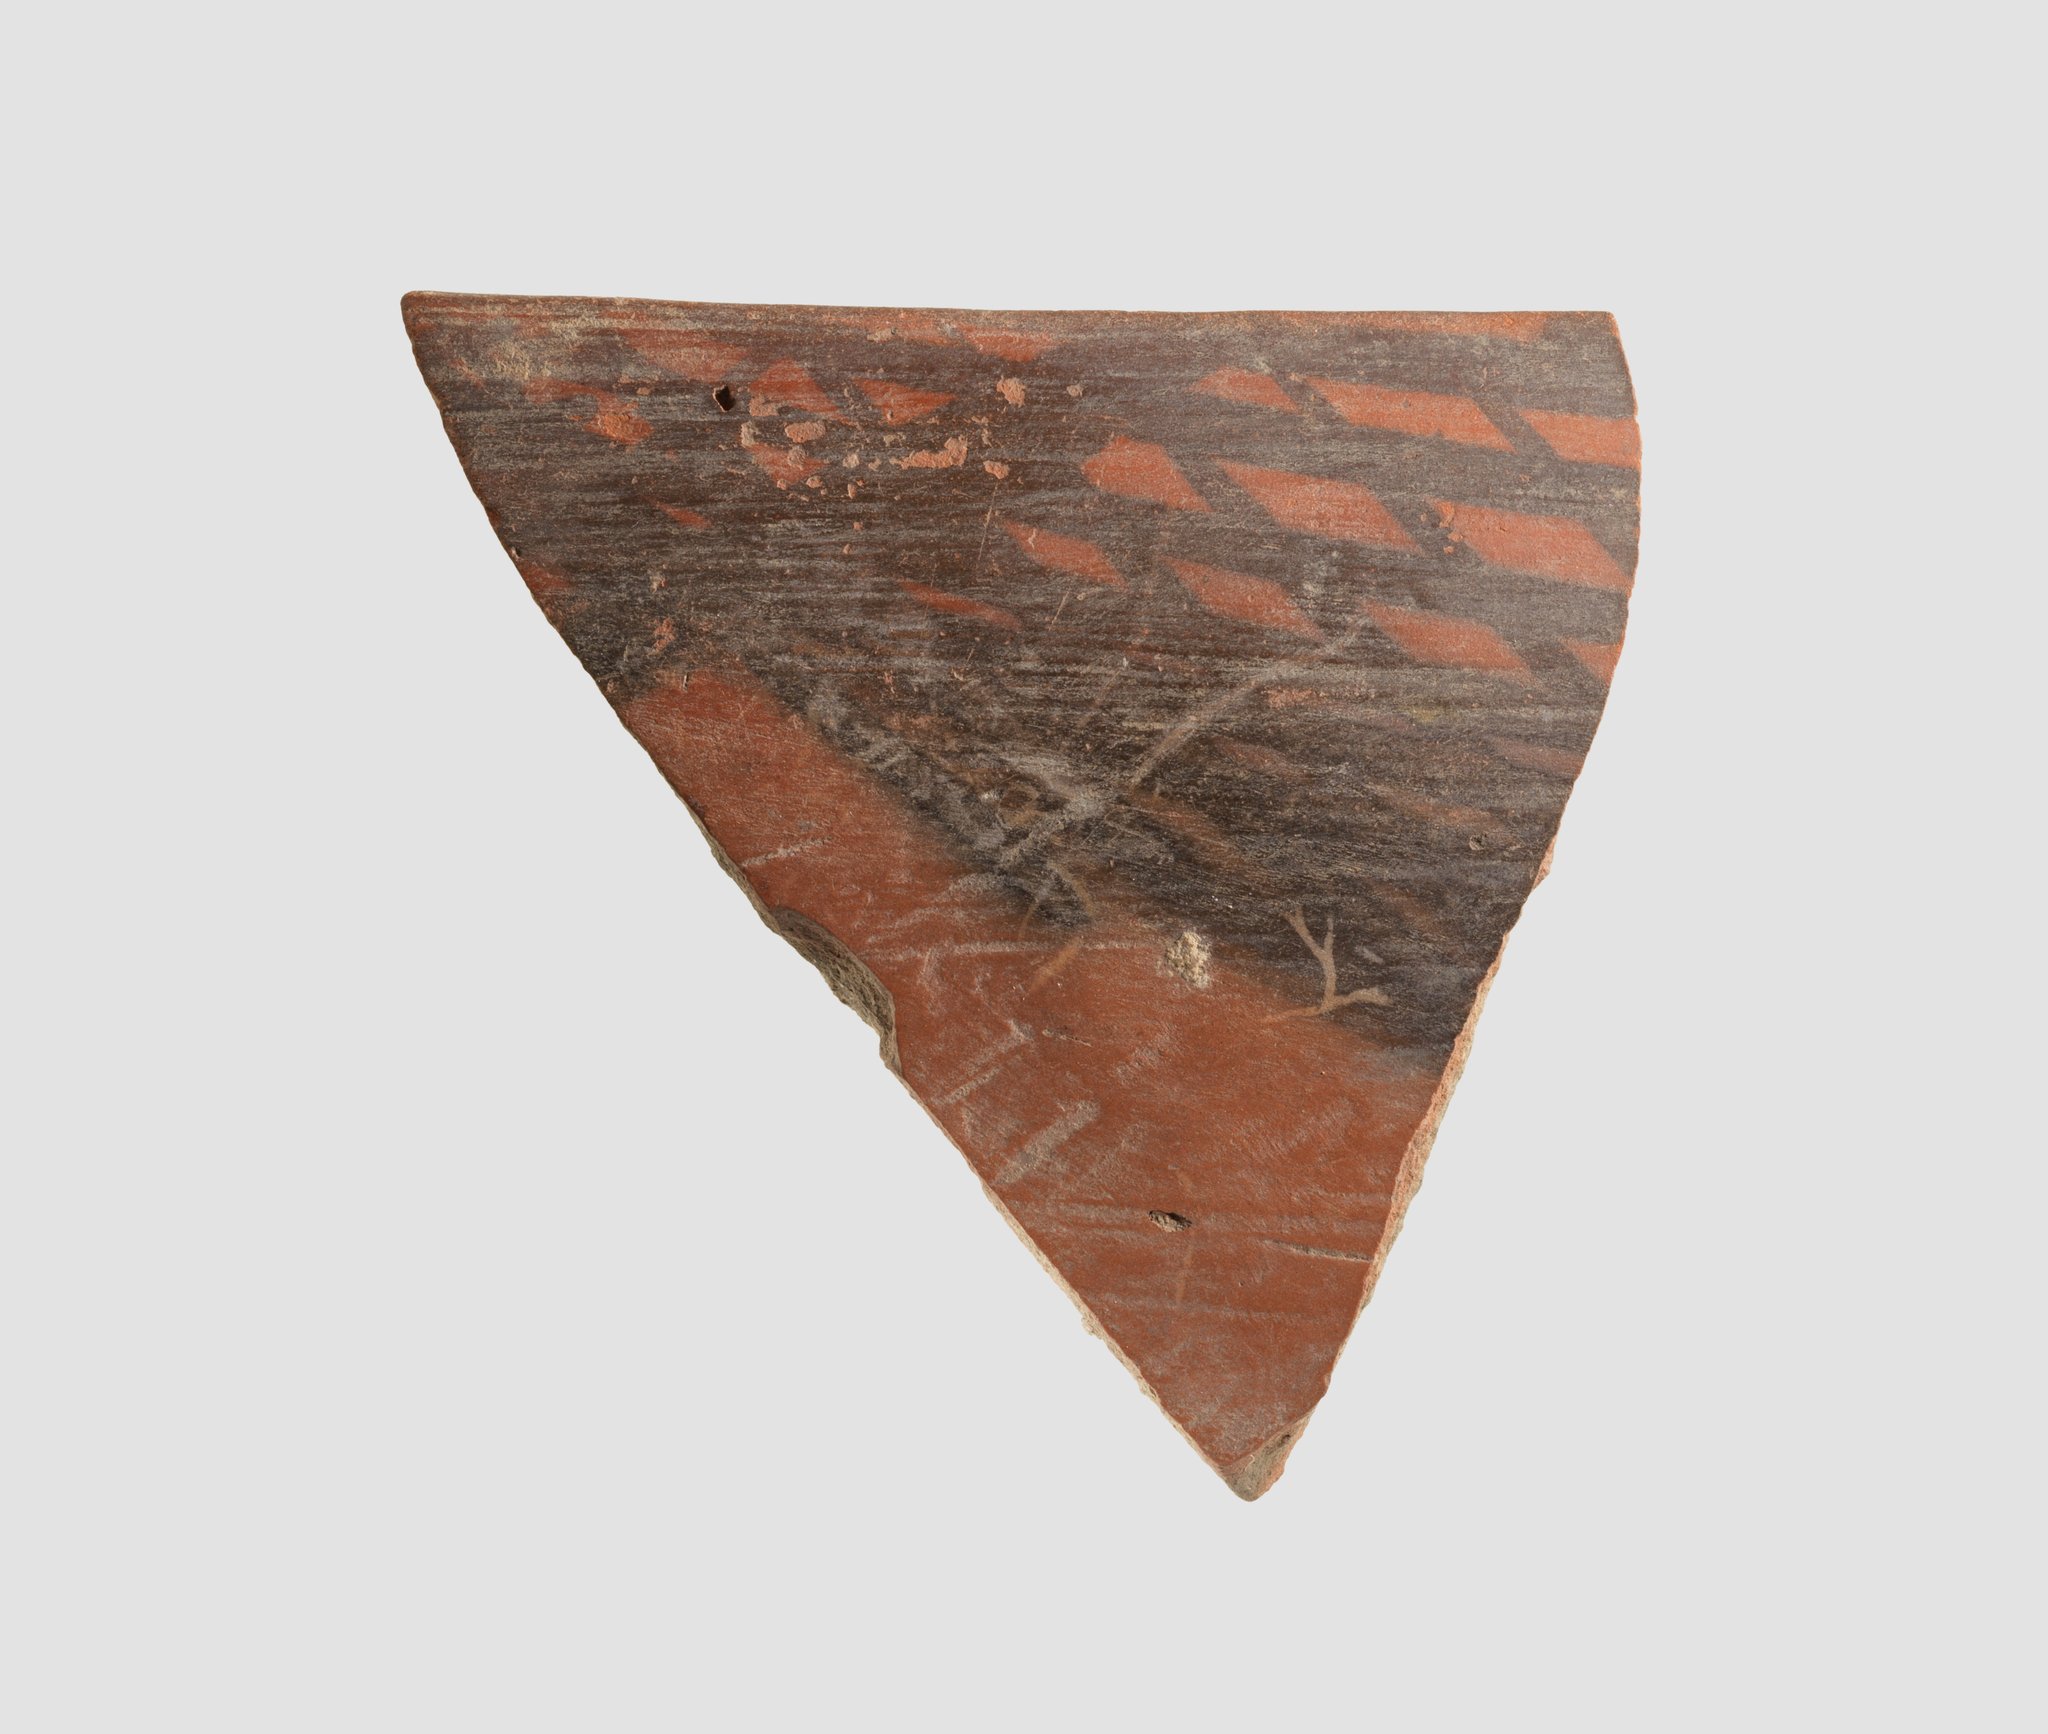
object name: sherd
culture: iranian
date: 4000-3500 BCE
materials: ceramic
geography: iran